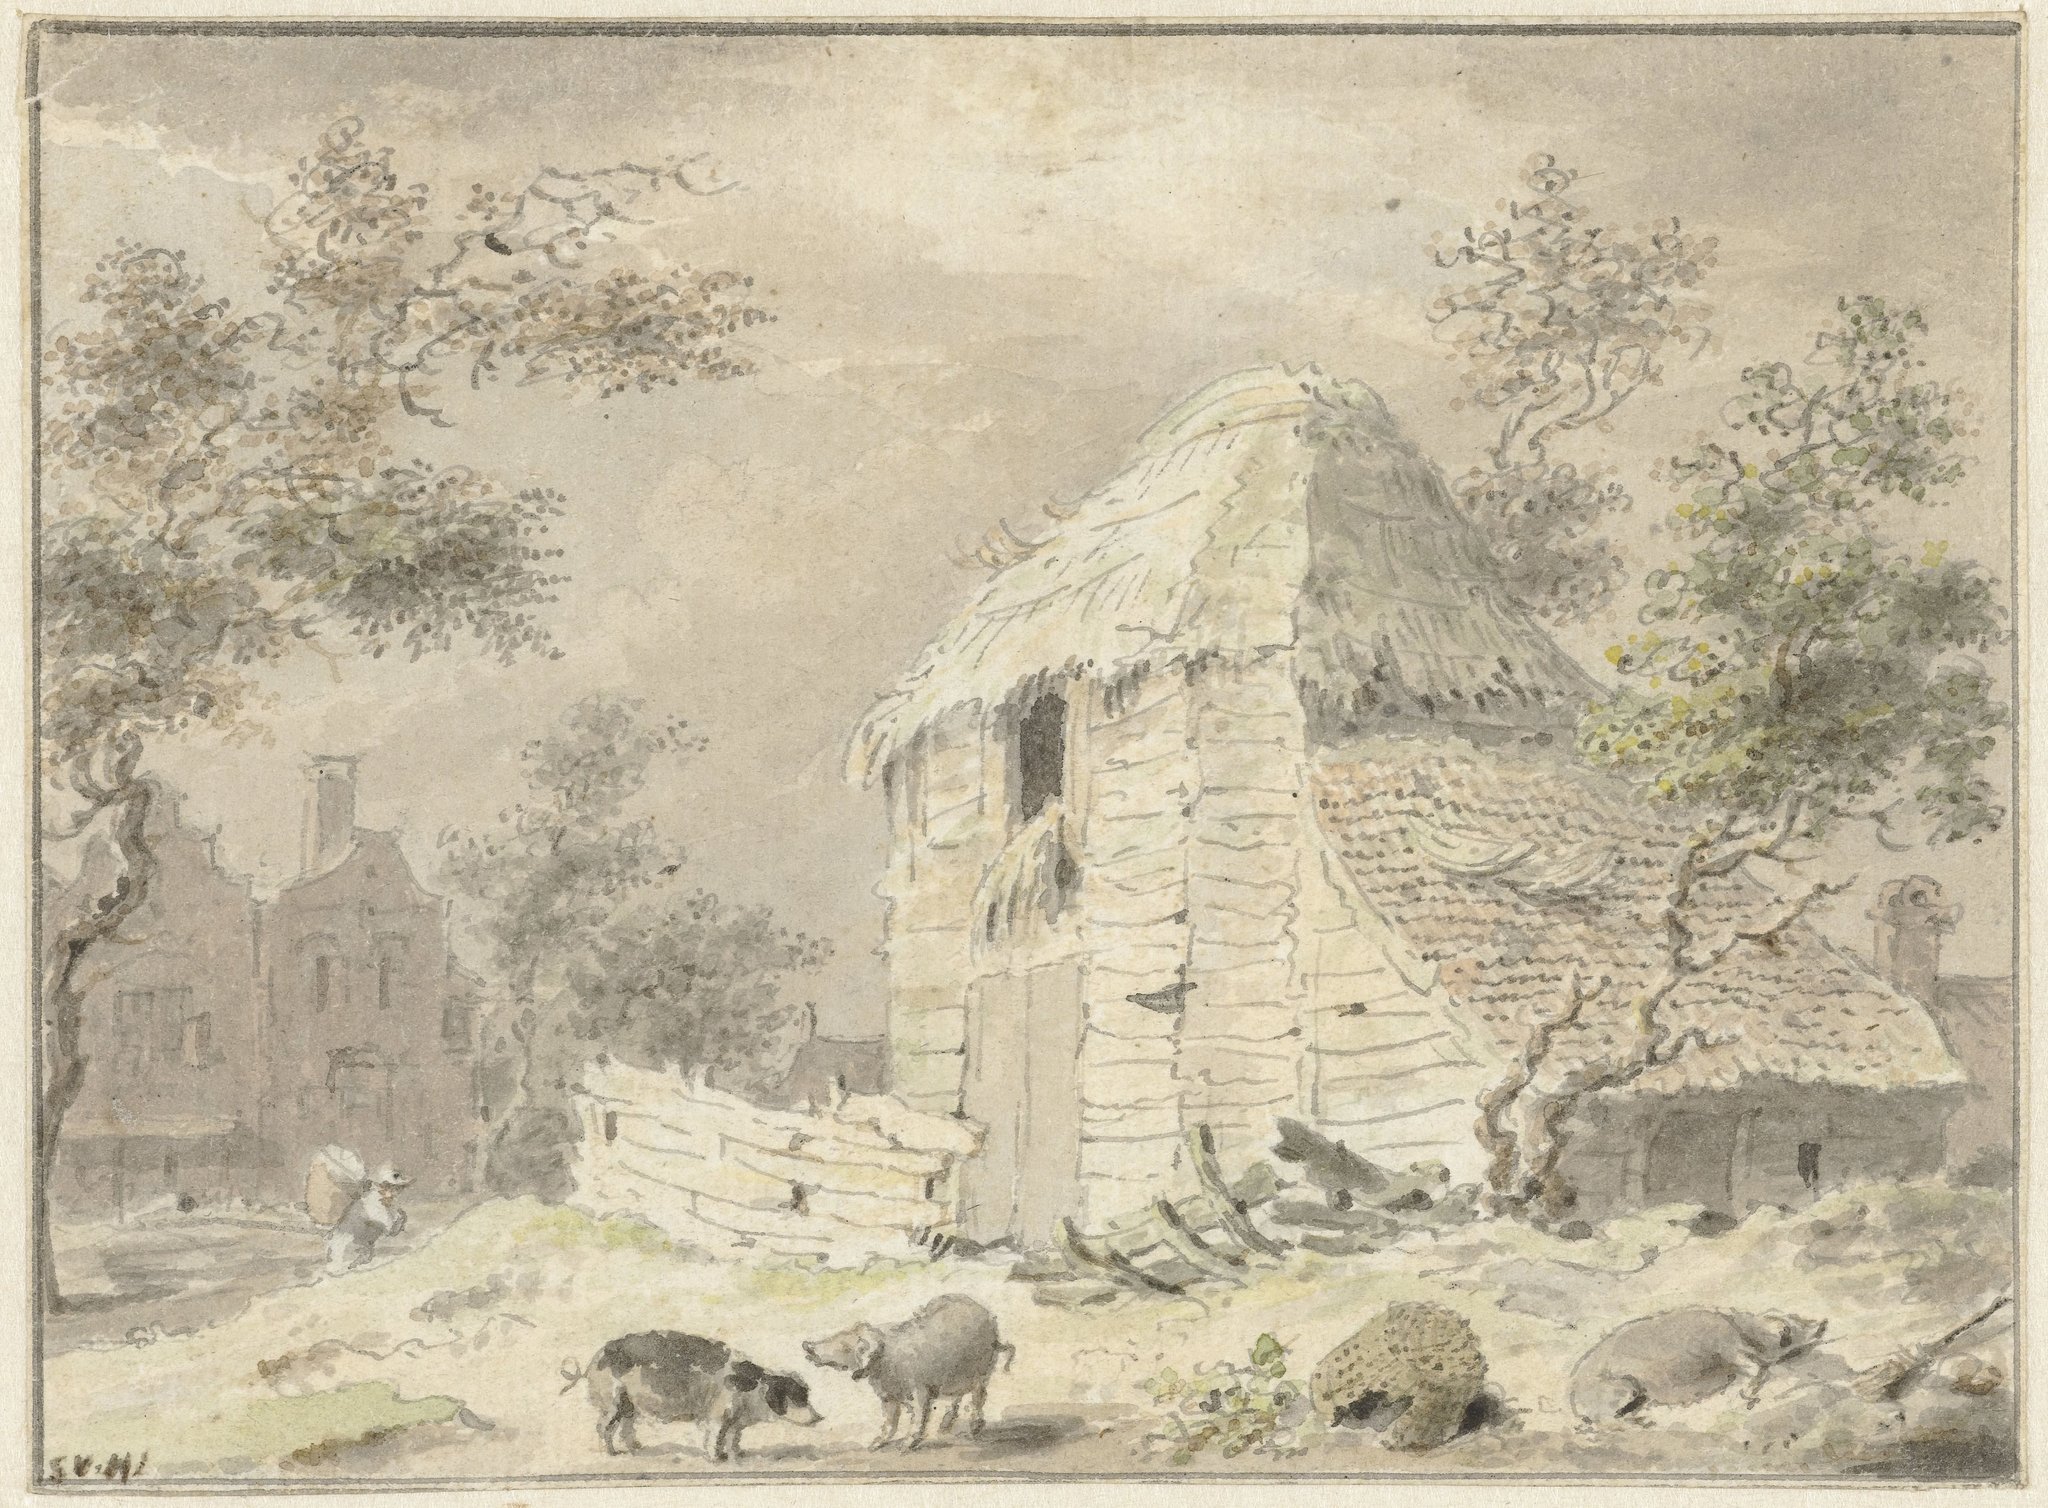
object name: drawing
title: Boerenschuur met enige varkens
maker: samuel van huls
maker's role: draughtsman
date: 1700-1800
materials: ink, paper, watercolor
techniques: brush, pen